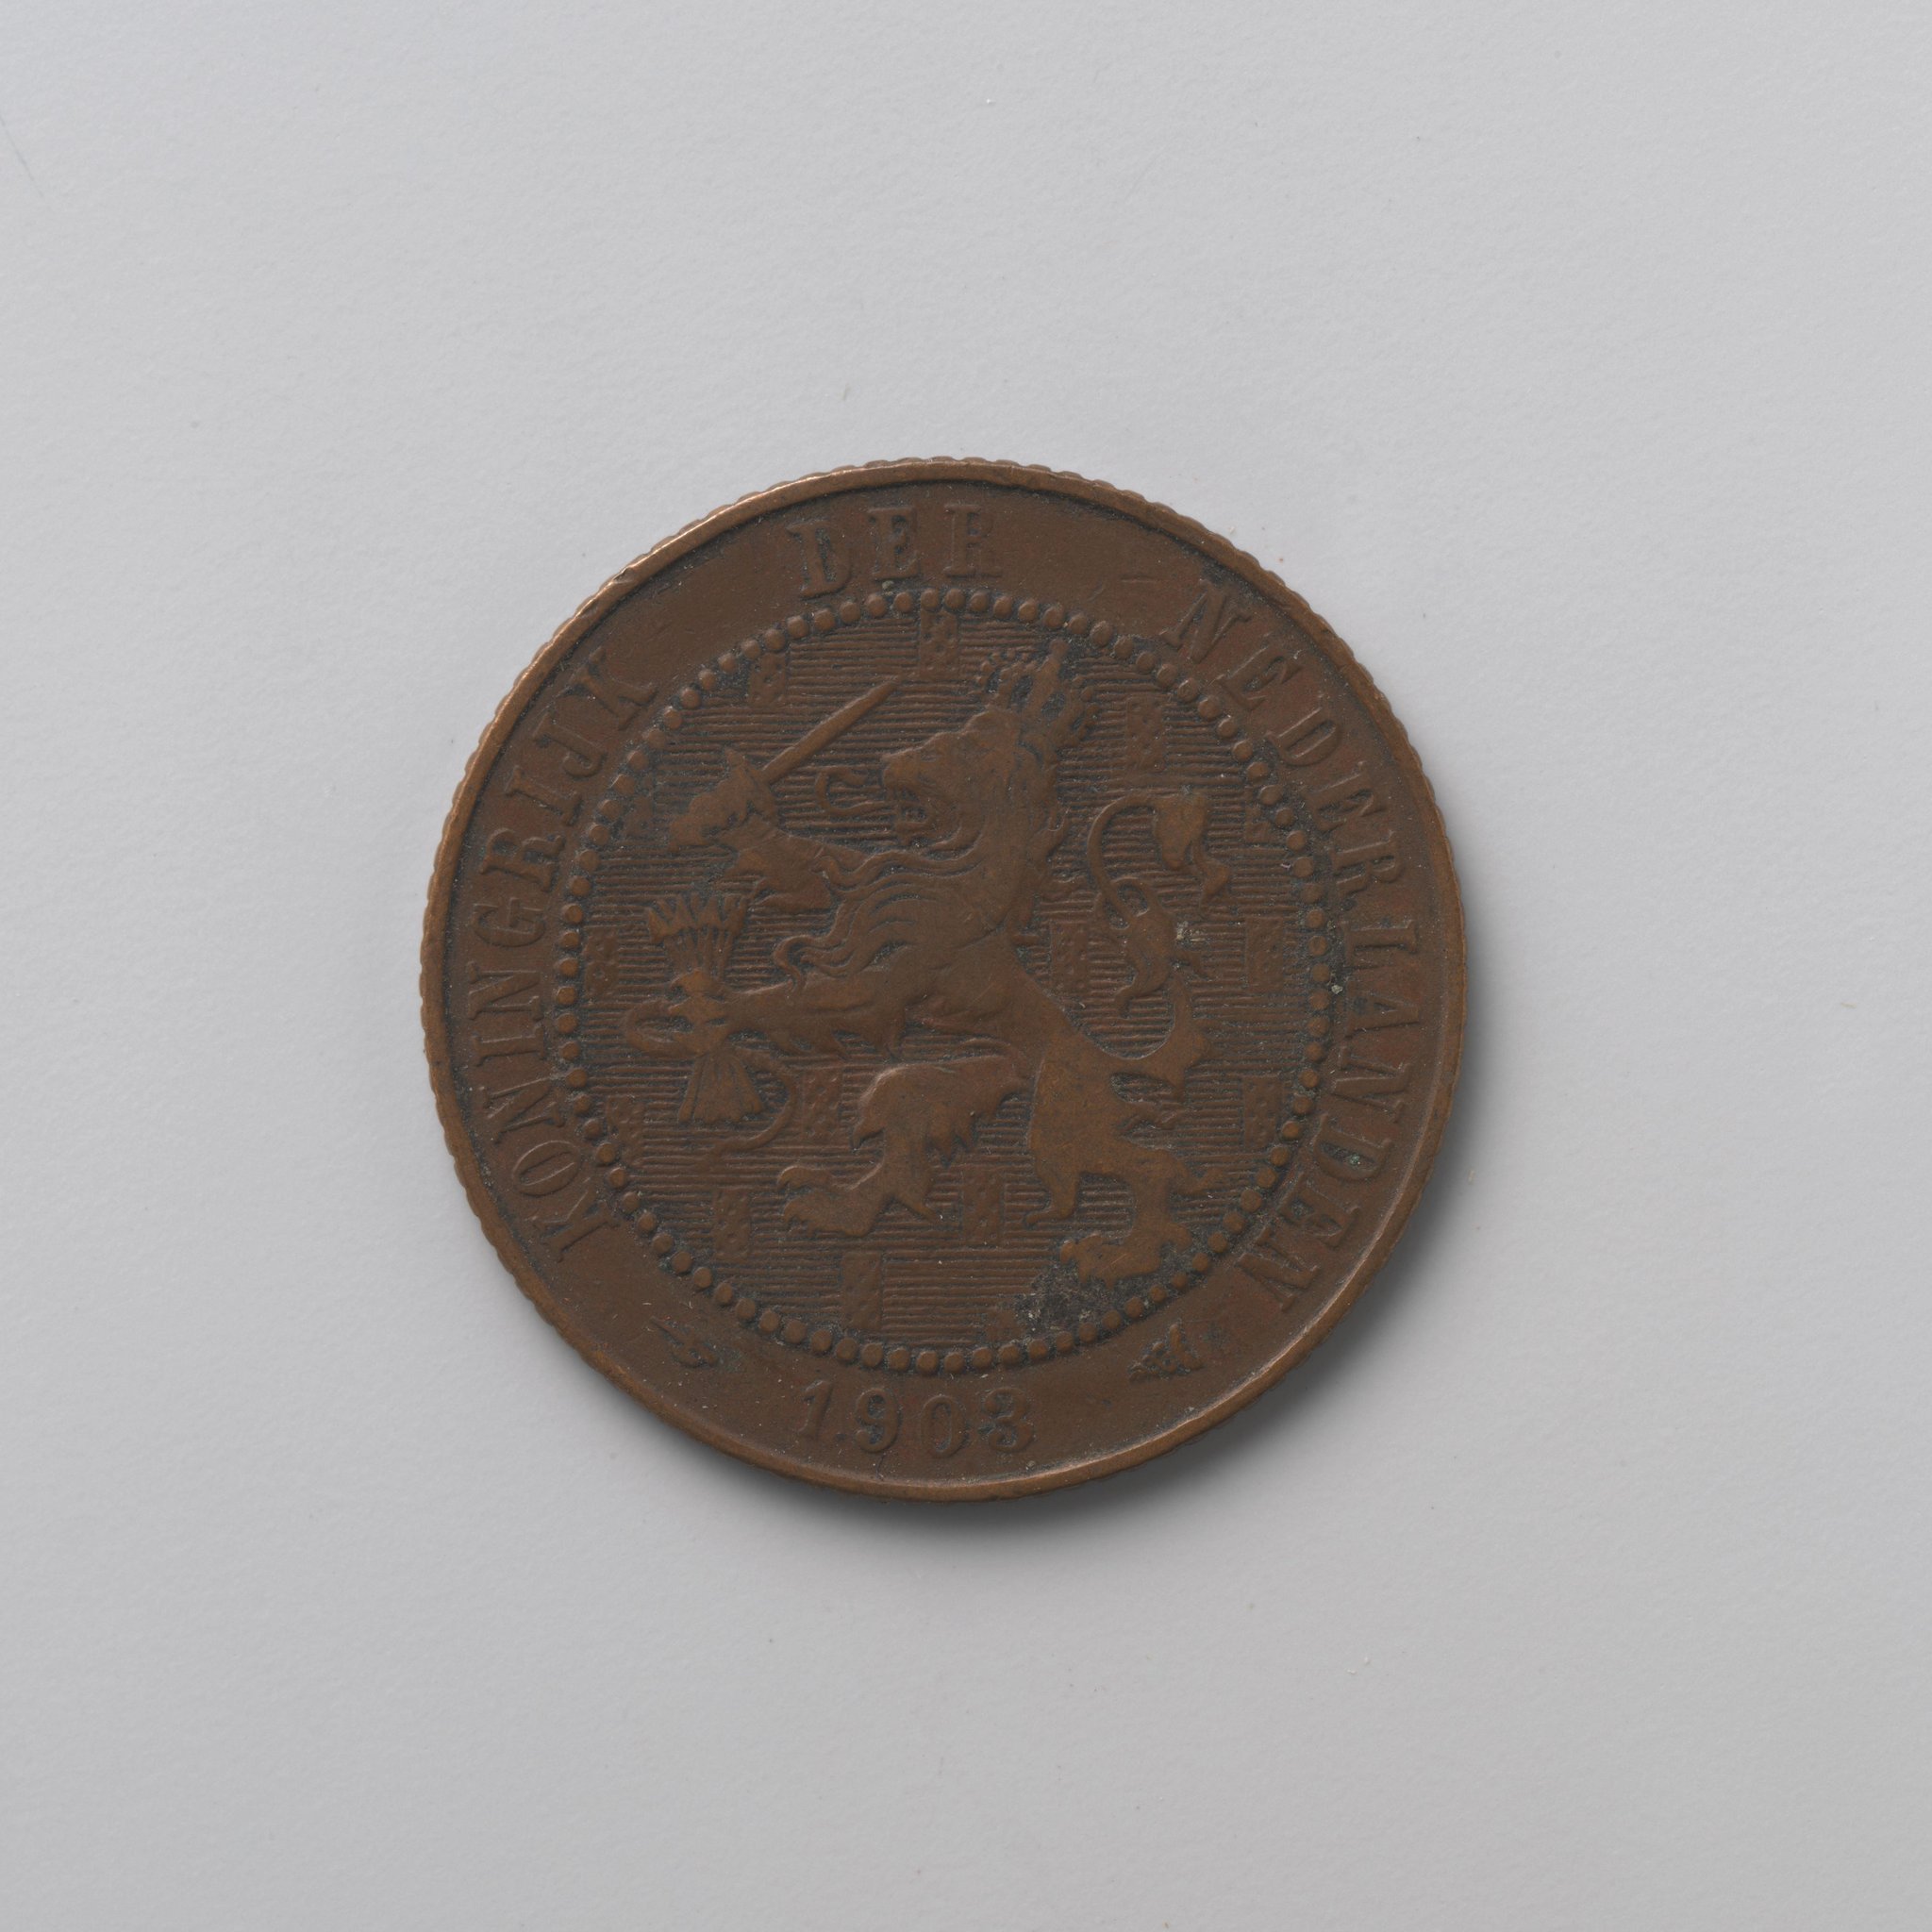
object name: twee en een halve cent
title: Nederland, 2½ cent,1903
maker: wilhelmina of the netherlands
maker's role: print maker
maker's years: 1880-1962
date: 1903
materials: bronze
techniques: striking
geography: utrecht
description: Bronzen munt. Voorzijde: in een veld rijkswapen. Jaartal onderaan in omschrift.Keerzijde: binnen twee samengebonden oranjetakken waarde-aanduiding 2½ cent. Kartelrand.